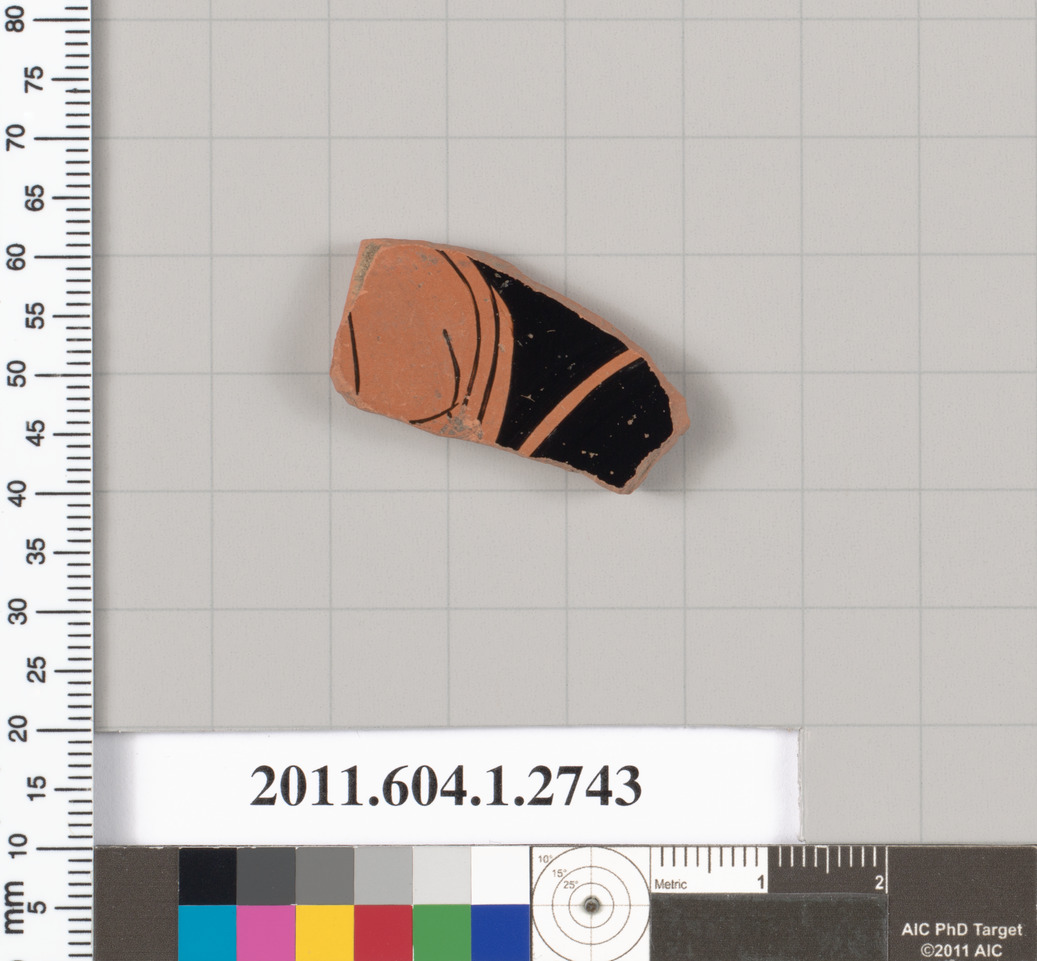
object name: kylix fragment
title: Terracotta fragment of a kylix (drinking cup)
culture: greek, attic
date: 490-470 BCE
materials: terracotta